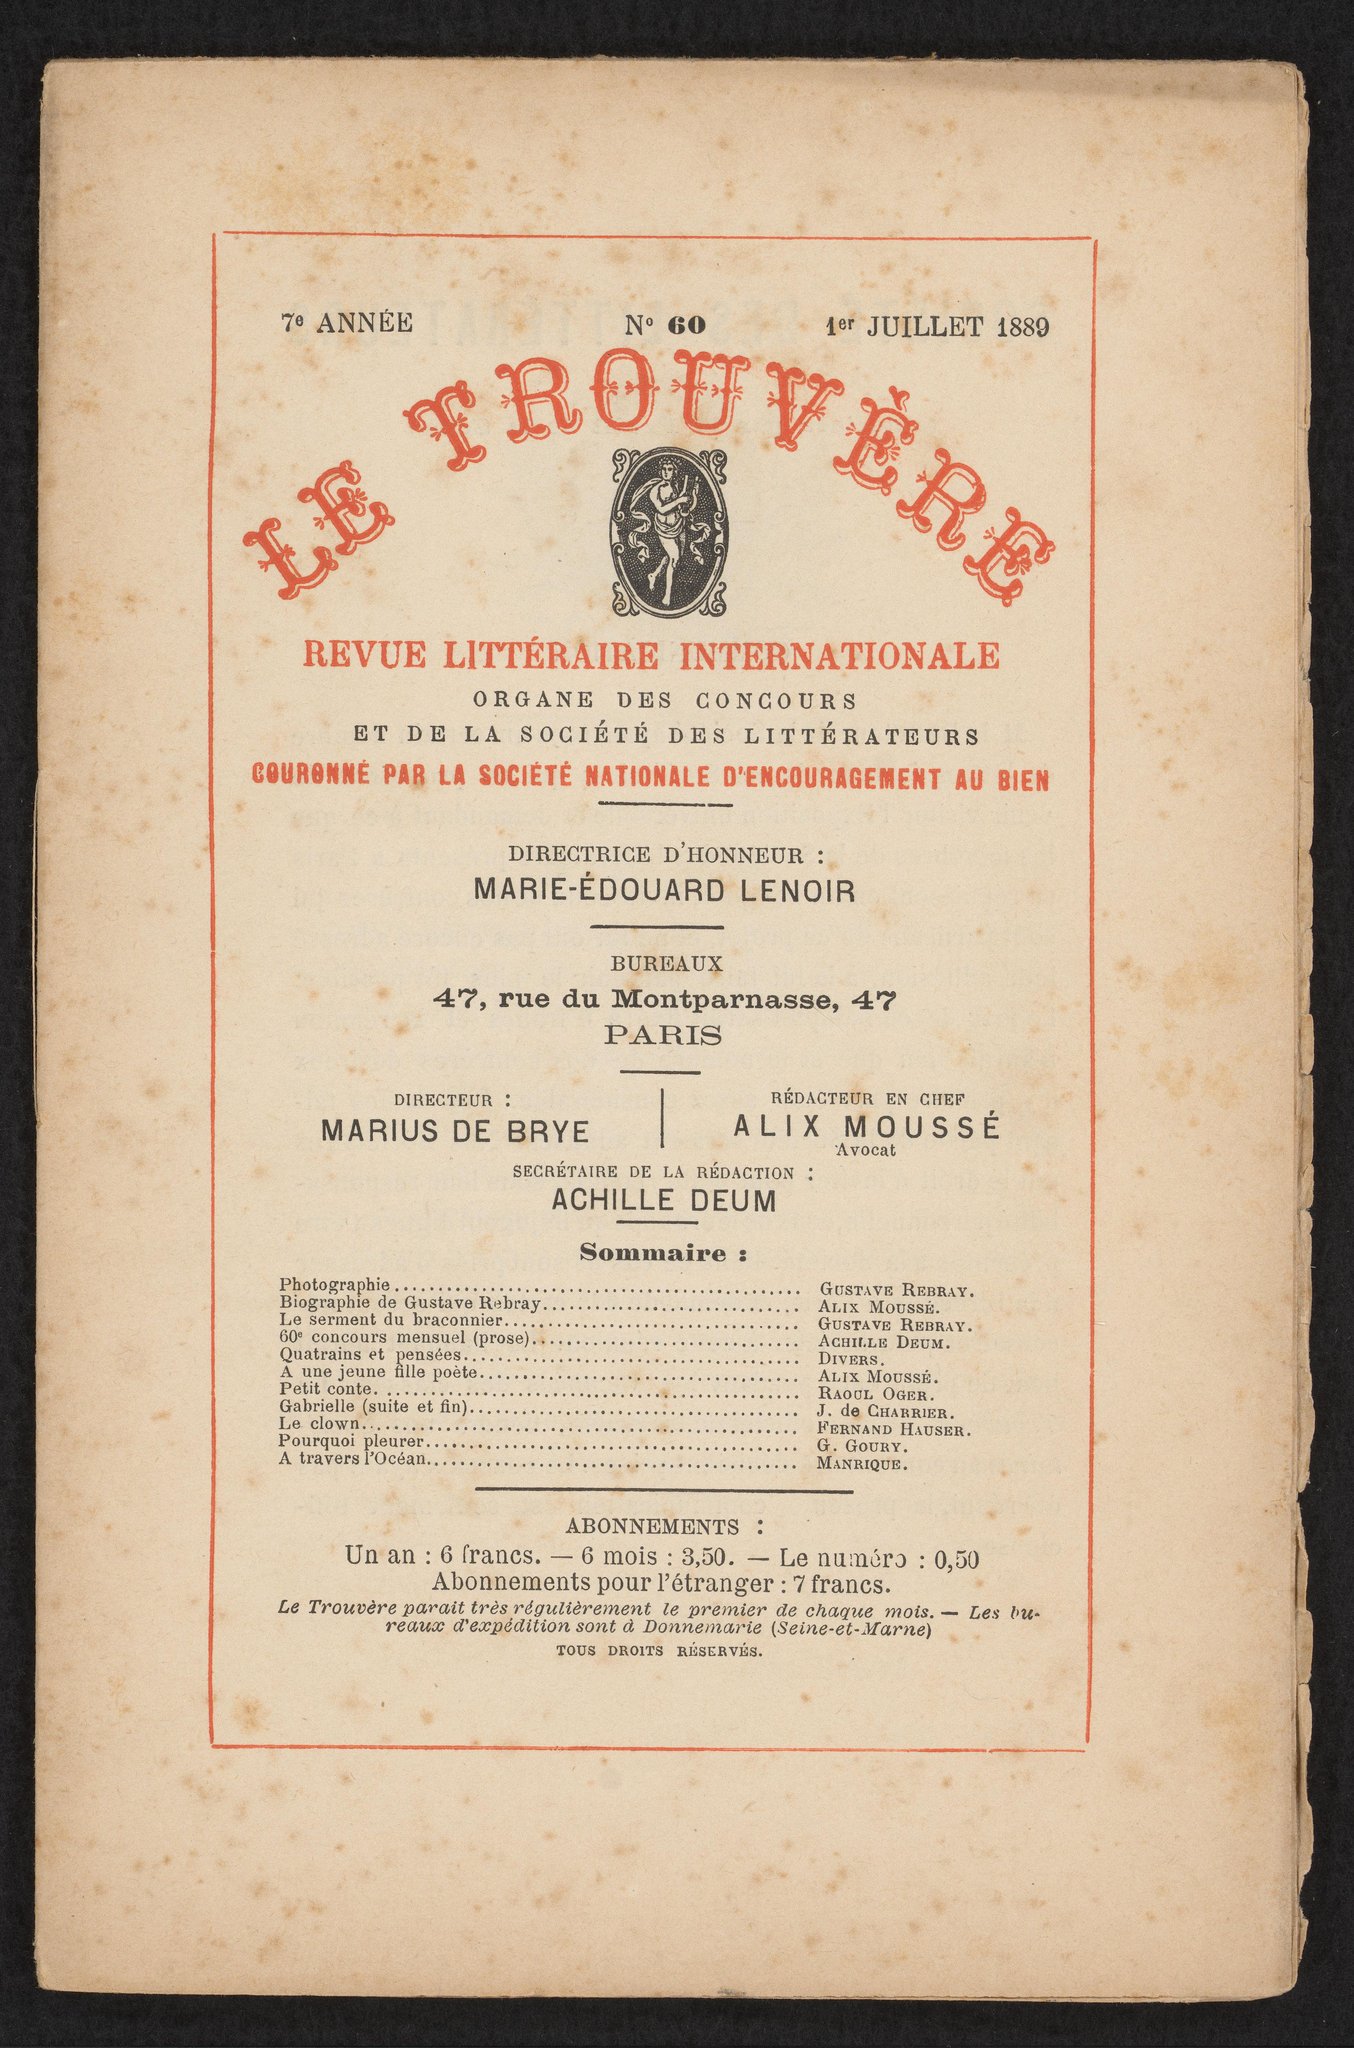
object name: book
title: Le trouvère No 60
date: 1807-1889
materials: paper, photographic support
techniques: albumen print, printing, engraving